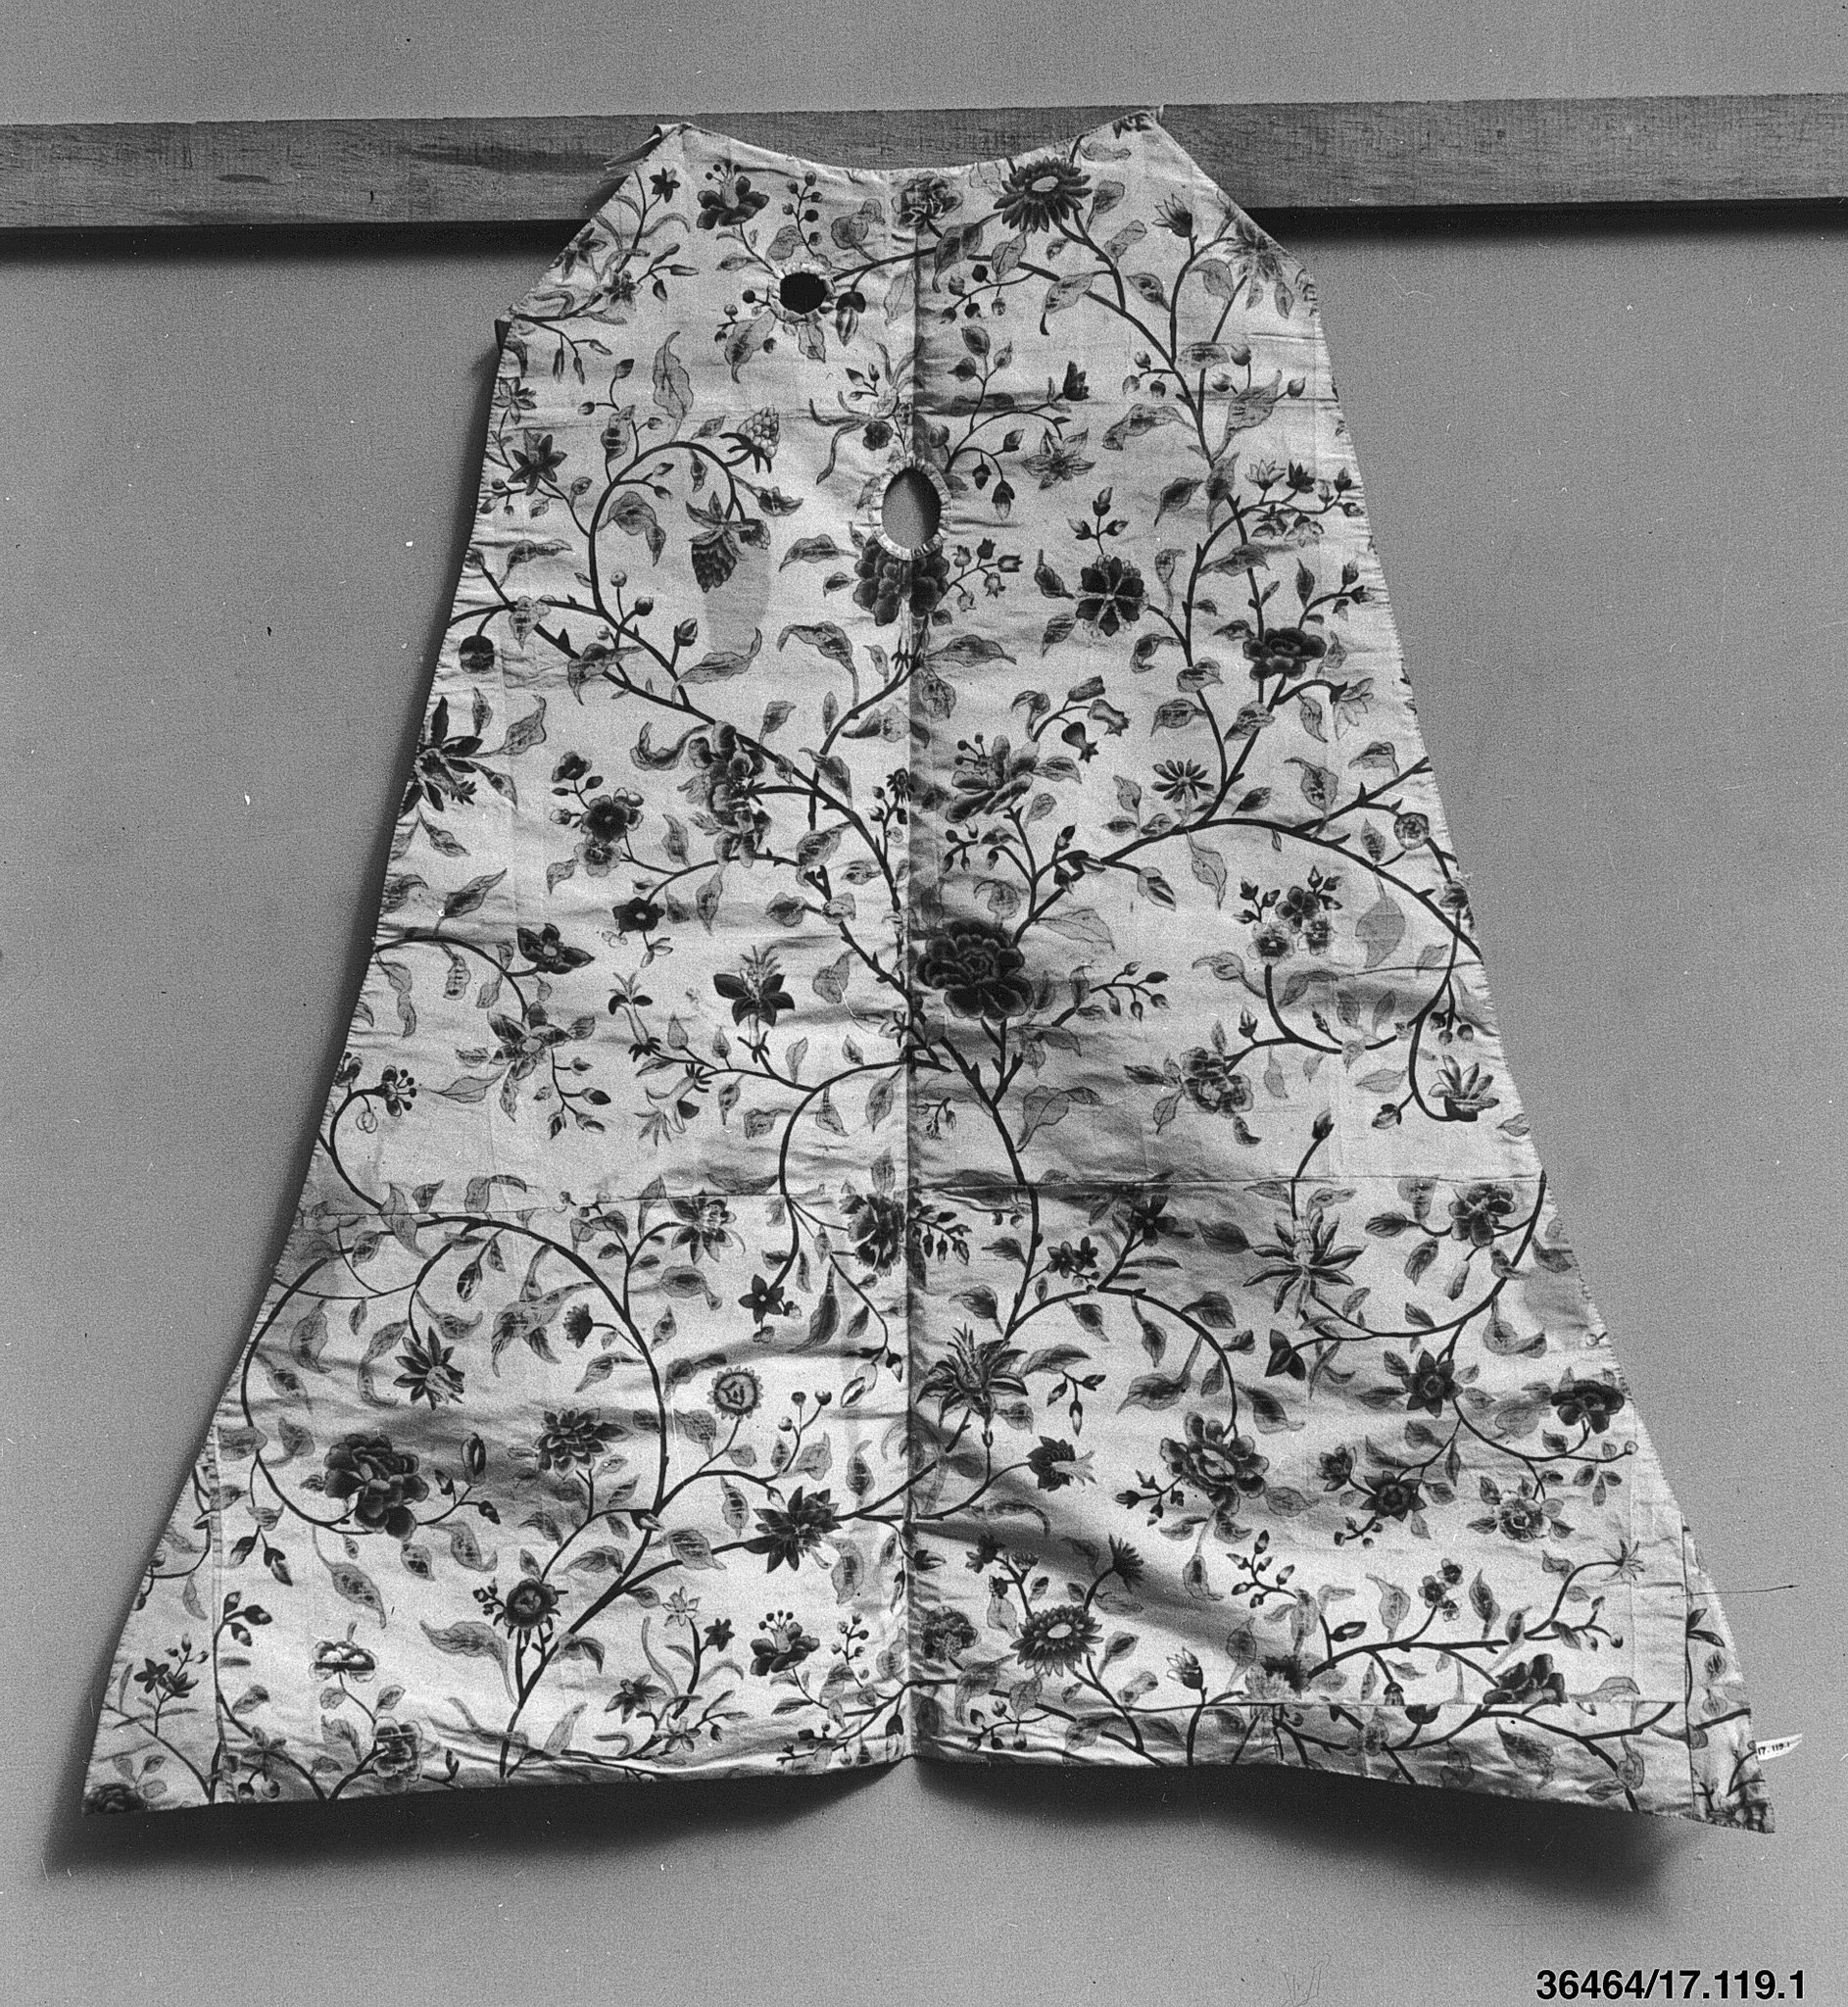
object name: statue robe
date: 1701-1800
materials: silk